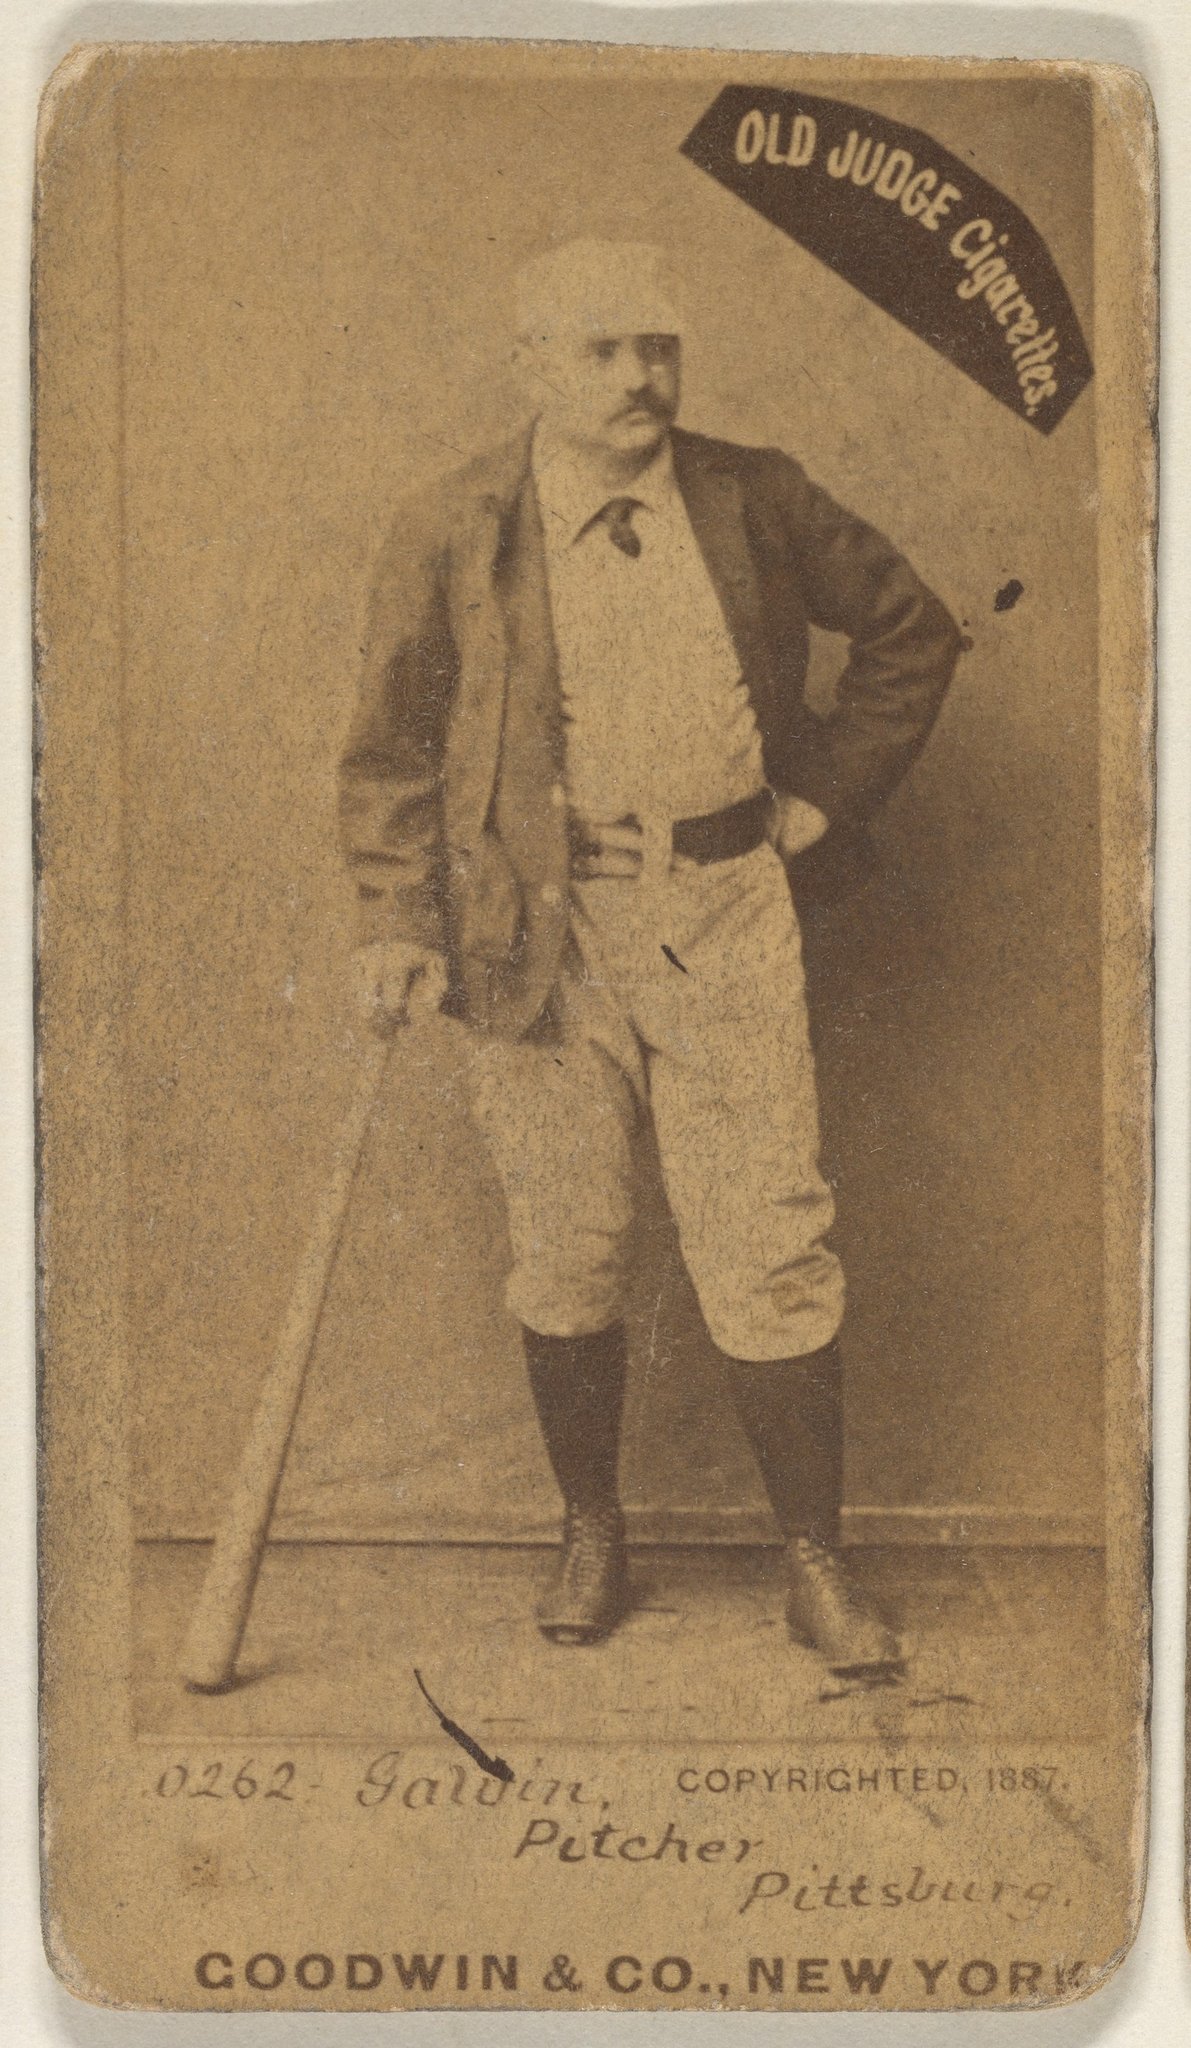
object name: baseball card, photograph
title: James Francis "Pud" Galvin, Pitcher, Pittsburgh, from the Old Judge series (N172) for Old Judge Cigarettes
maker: goodwin & company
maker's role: publisher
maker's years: 1850-1950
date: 1887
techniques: albumen silver print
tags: men,portraits,baseball,athletes